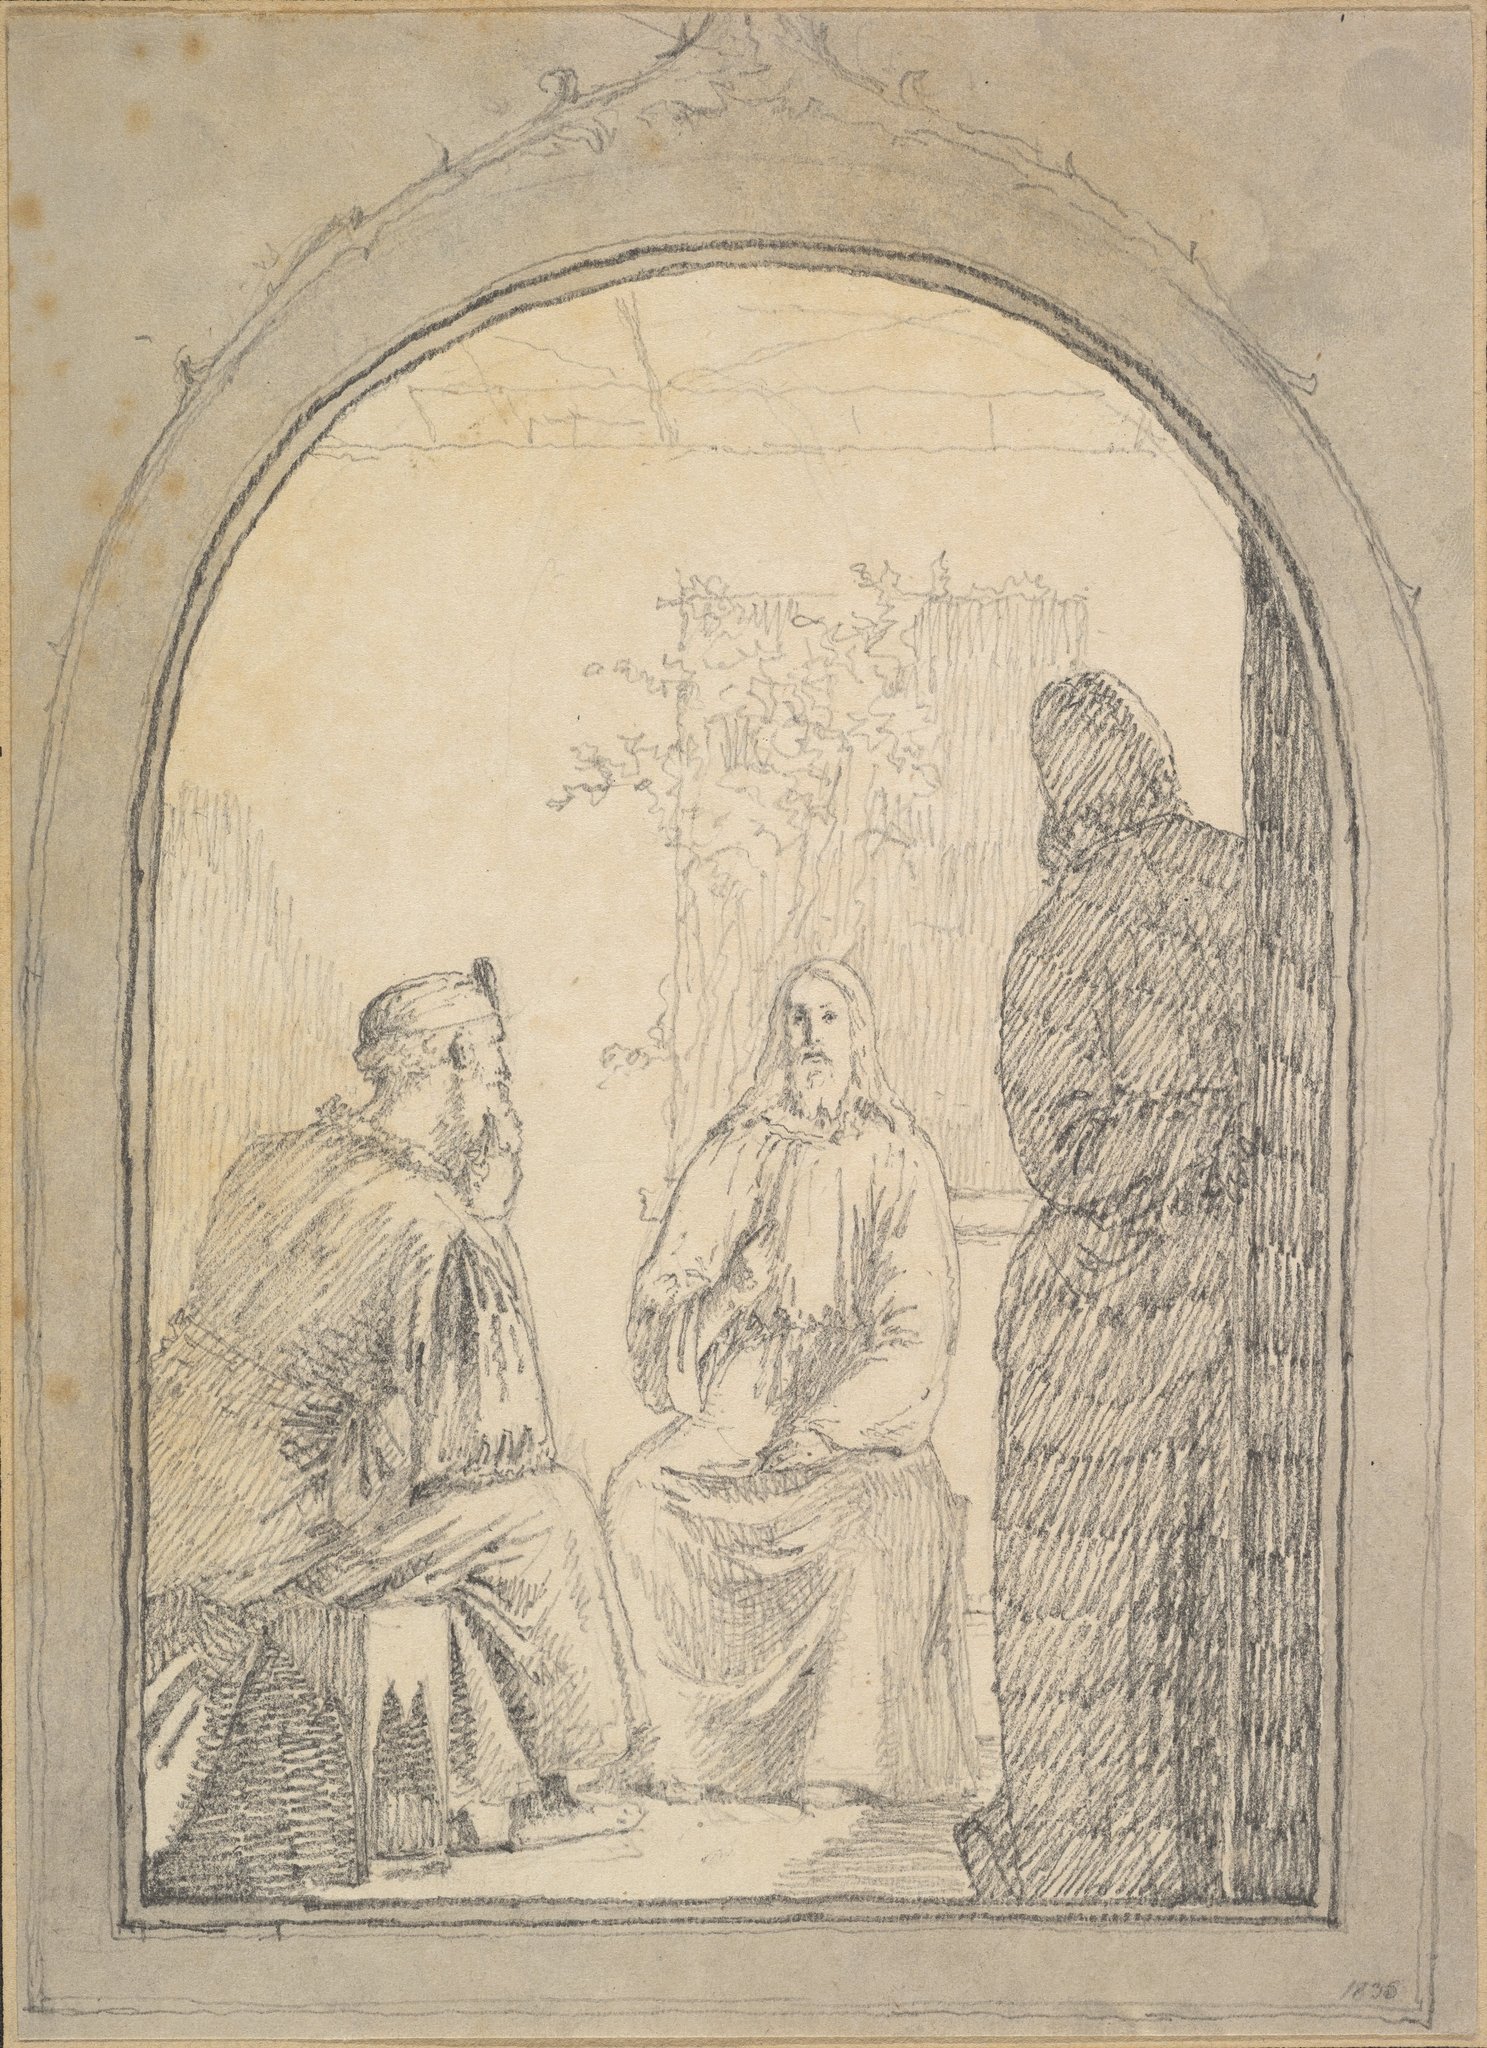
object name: drawing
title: Christ and Nicodemus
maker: christen købke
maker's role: artist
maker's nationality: danish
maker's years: 1810-1848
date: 1810-1848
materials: graphite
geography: denmark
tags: men,christ